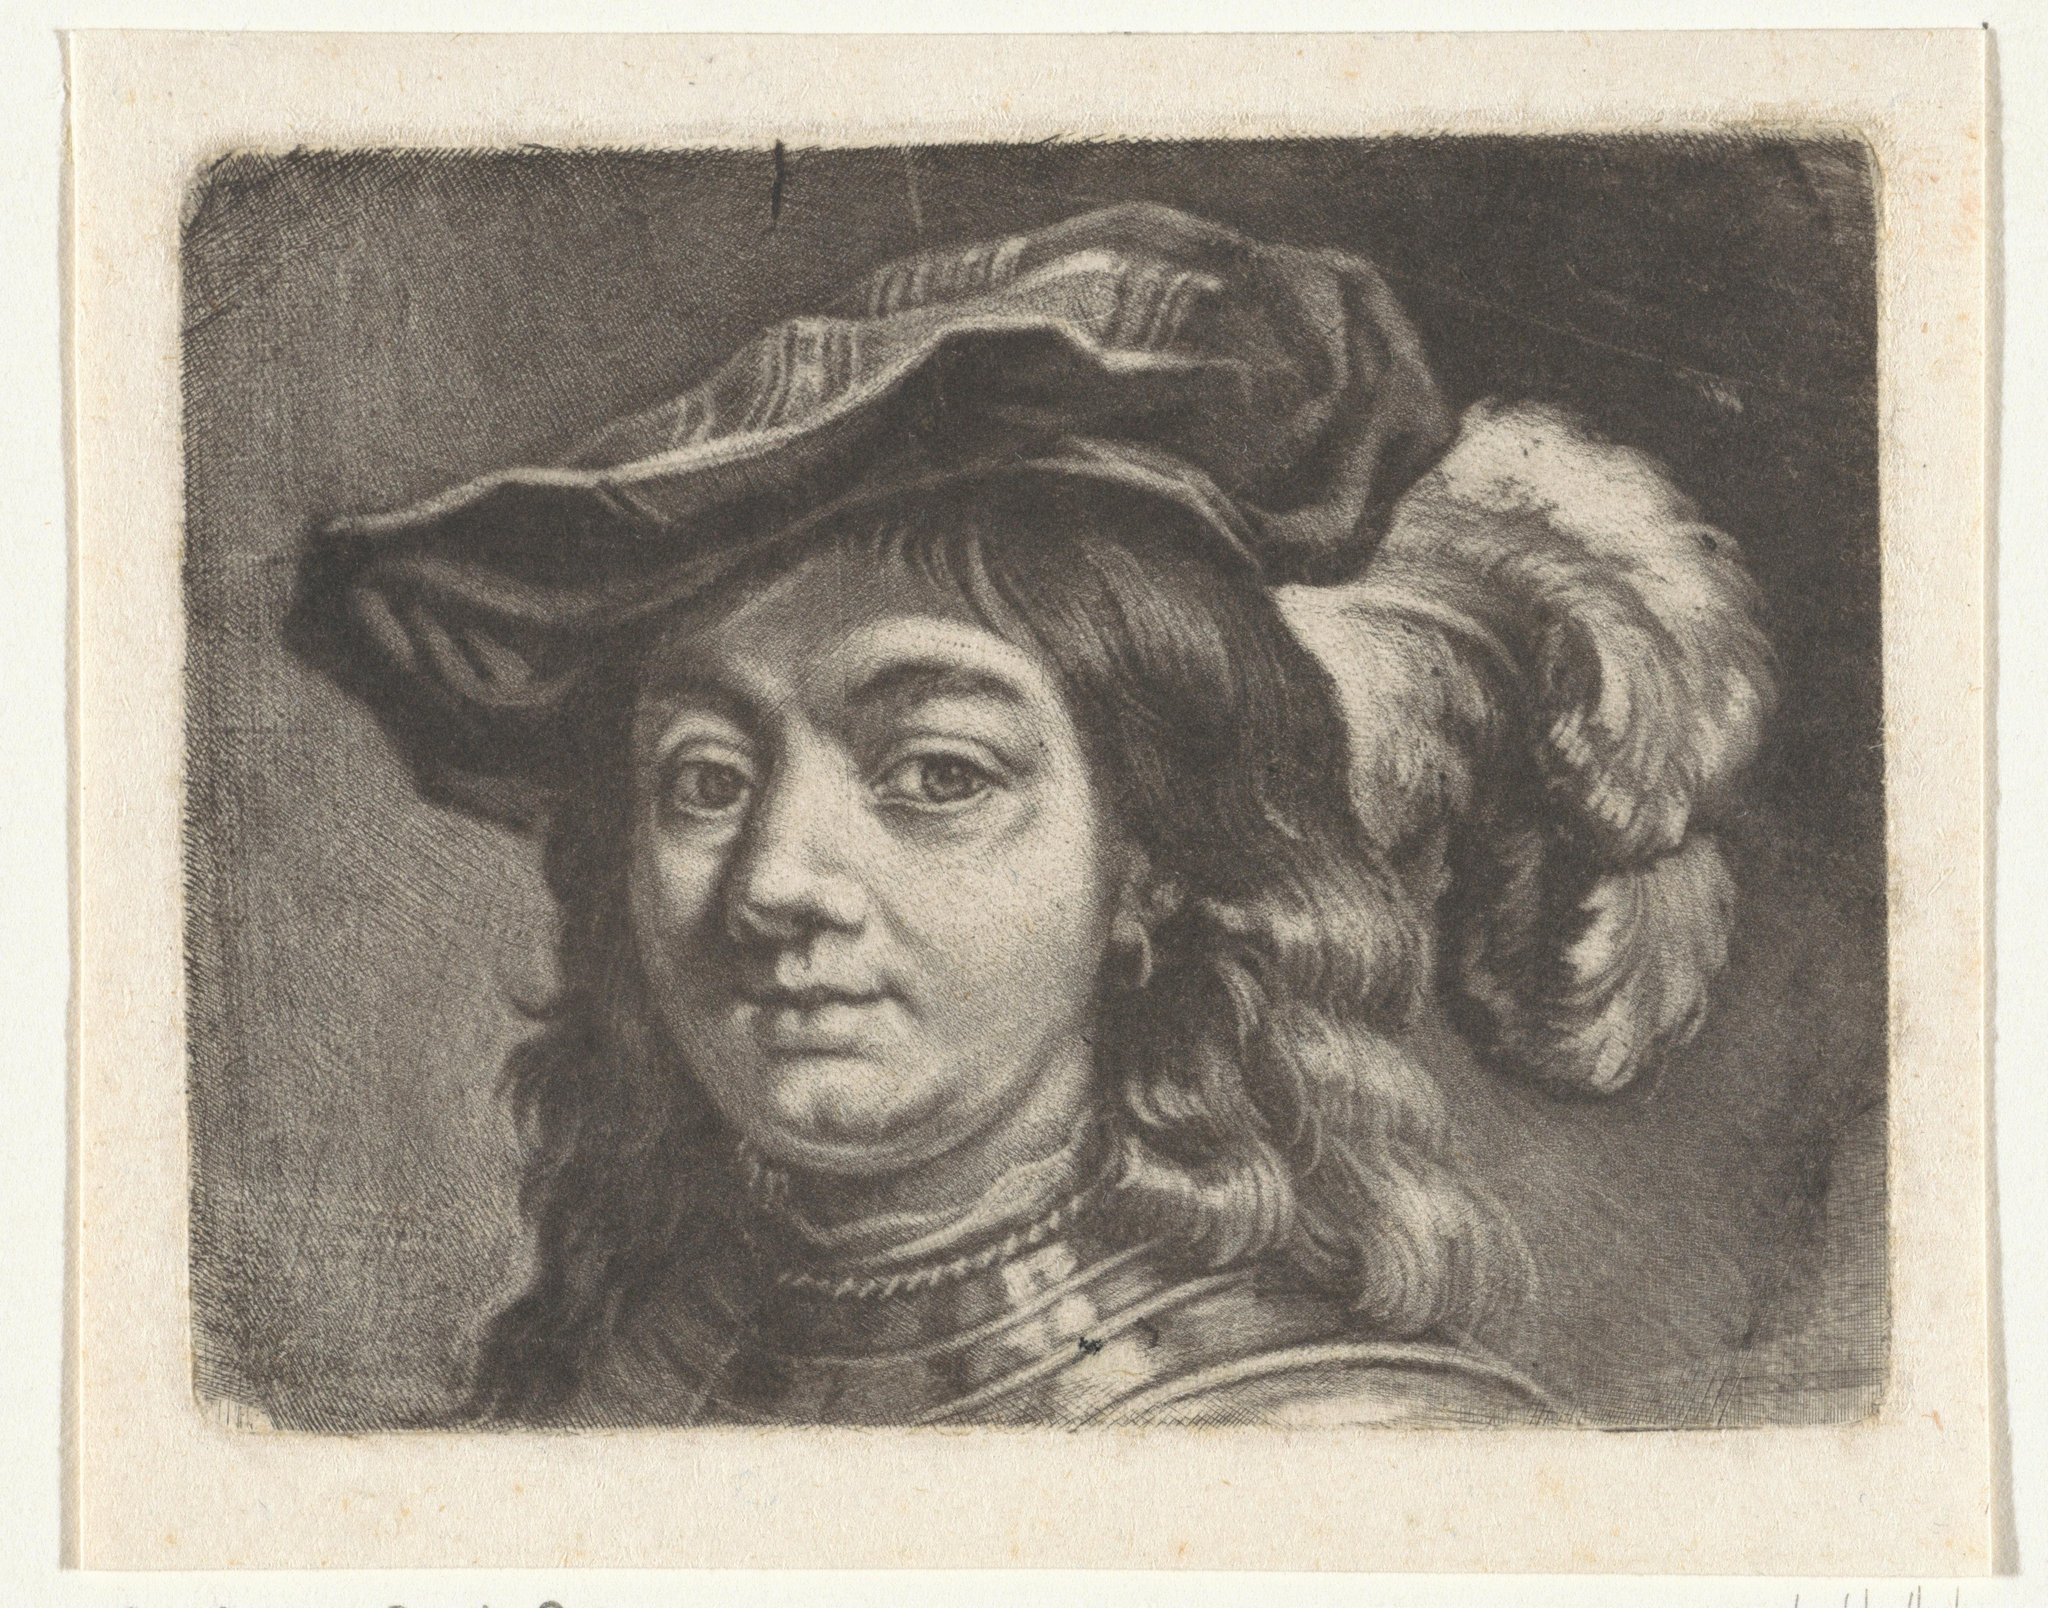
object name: print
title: Portret van een man met een muts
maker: godfried schalcken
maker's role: draughtsman, painter, print maker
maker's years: 1643-1706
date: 1653-1706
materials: paper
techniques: mezzotint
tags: head-gear: cap (+ men's clothes)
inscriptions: collector's mark: Lugt 514